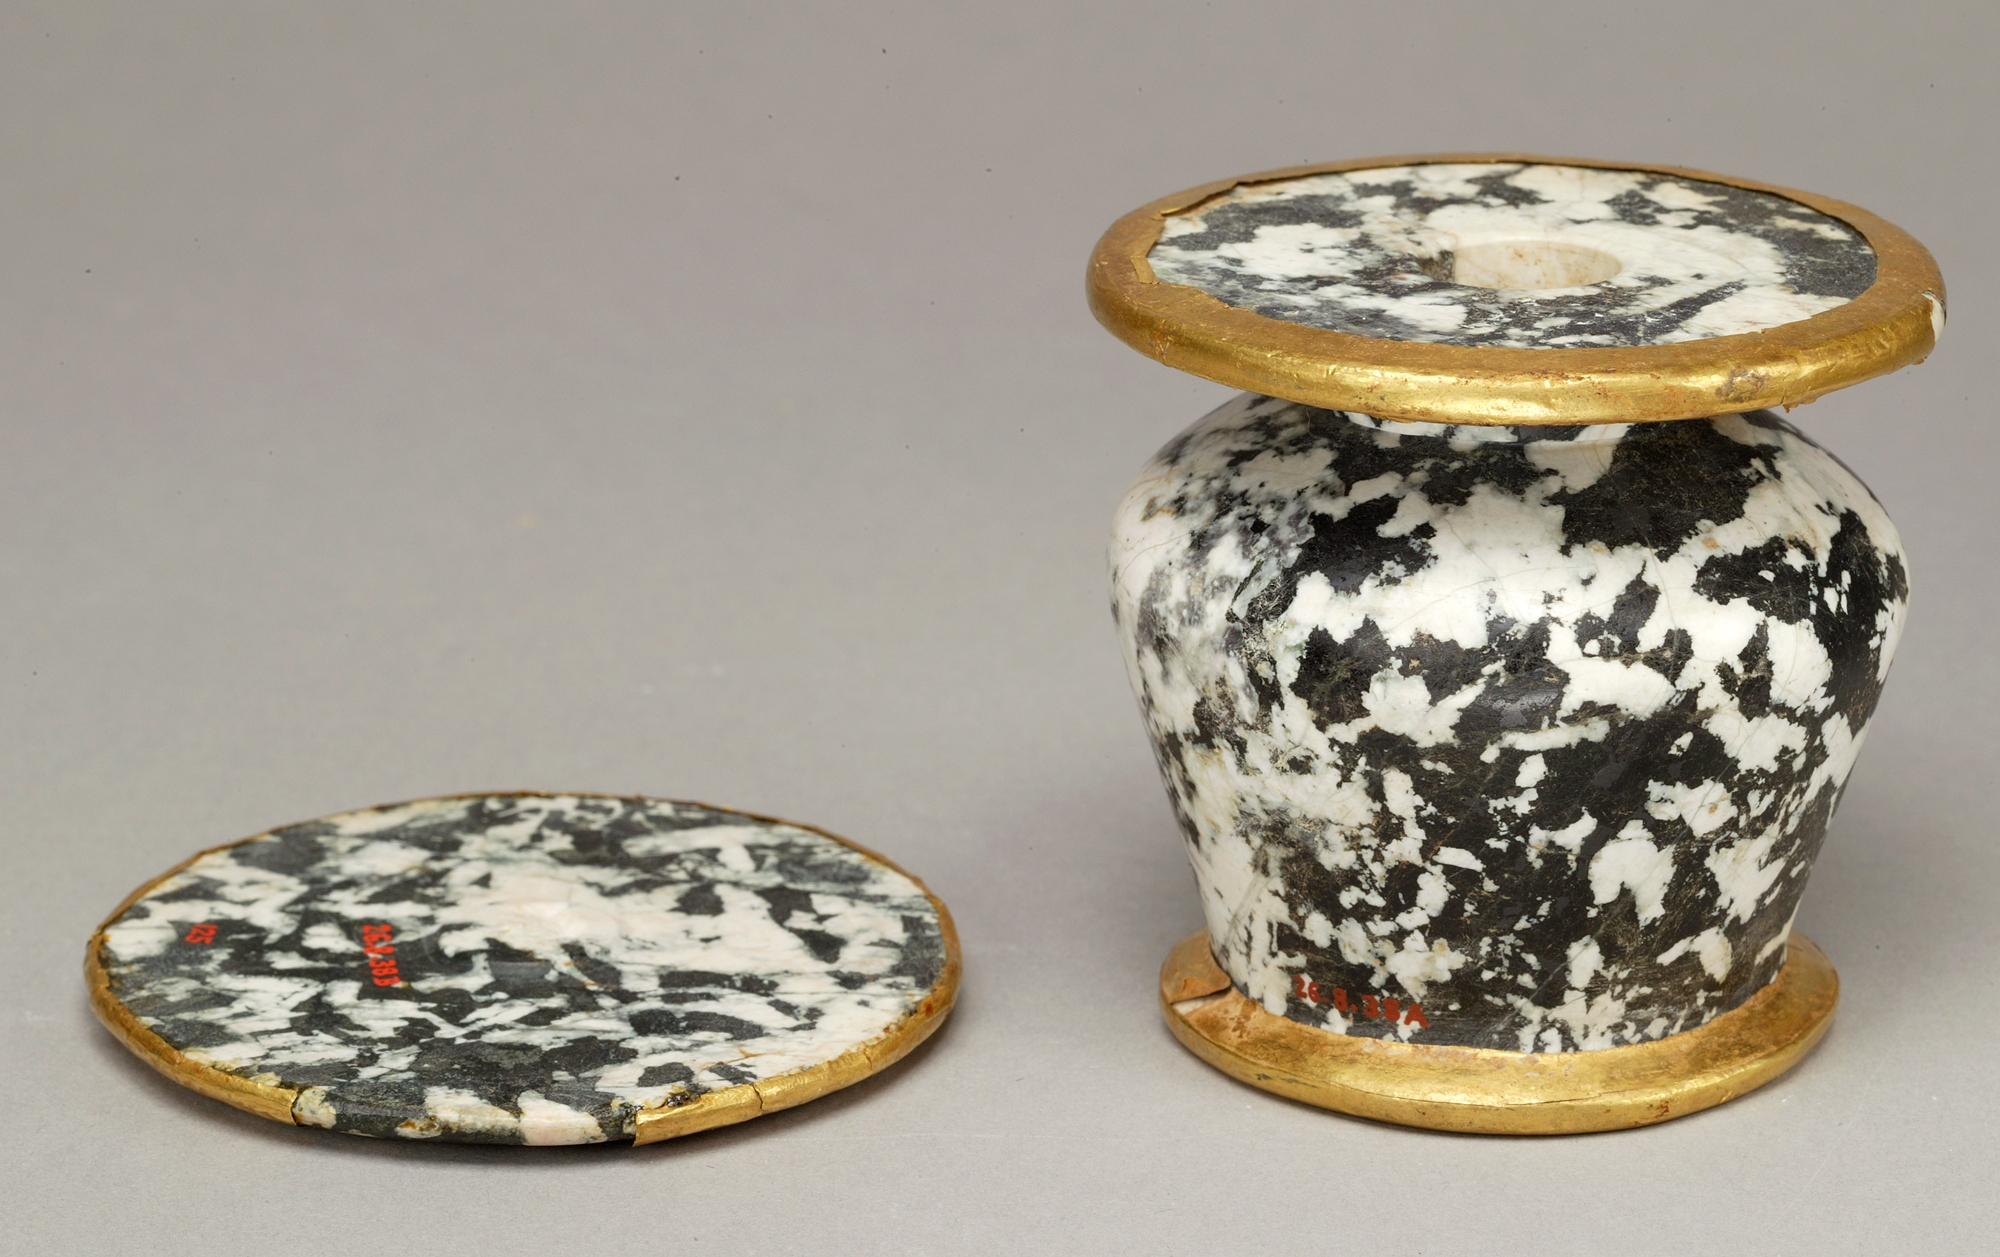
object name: kohl jar, thutmose iii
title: Kohl Jar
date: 1479-1425 BCE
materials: gold leaf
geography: egypt